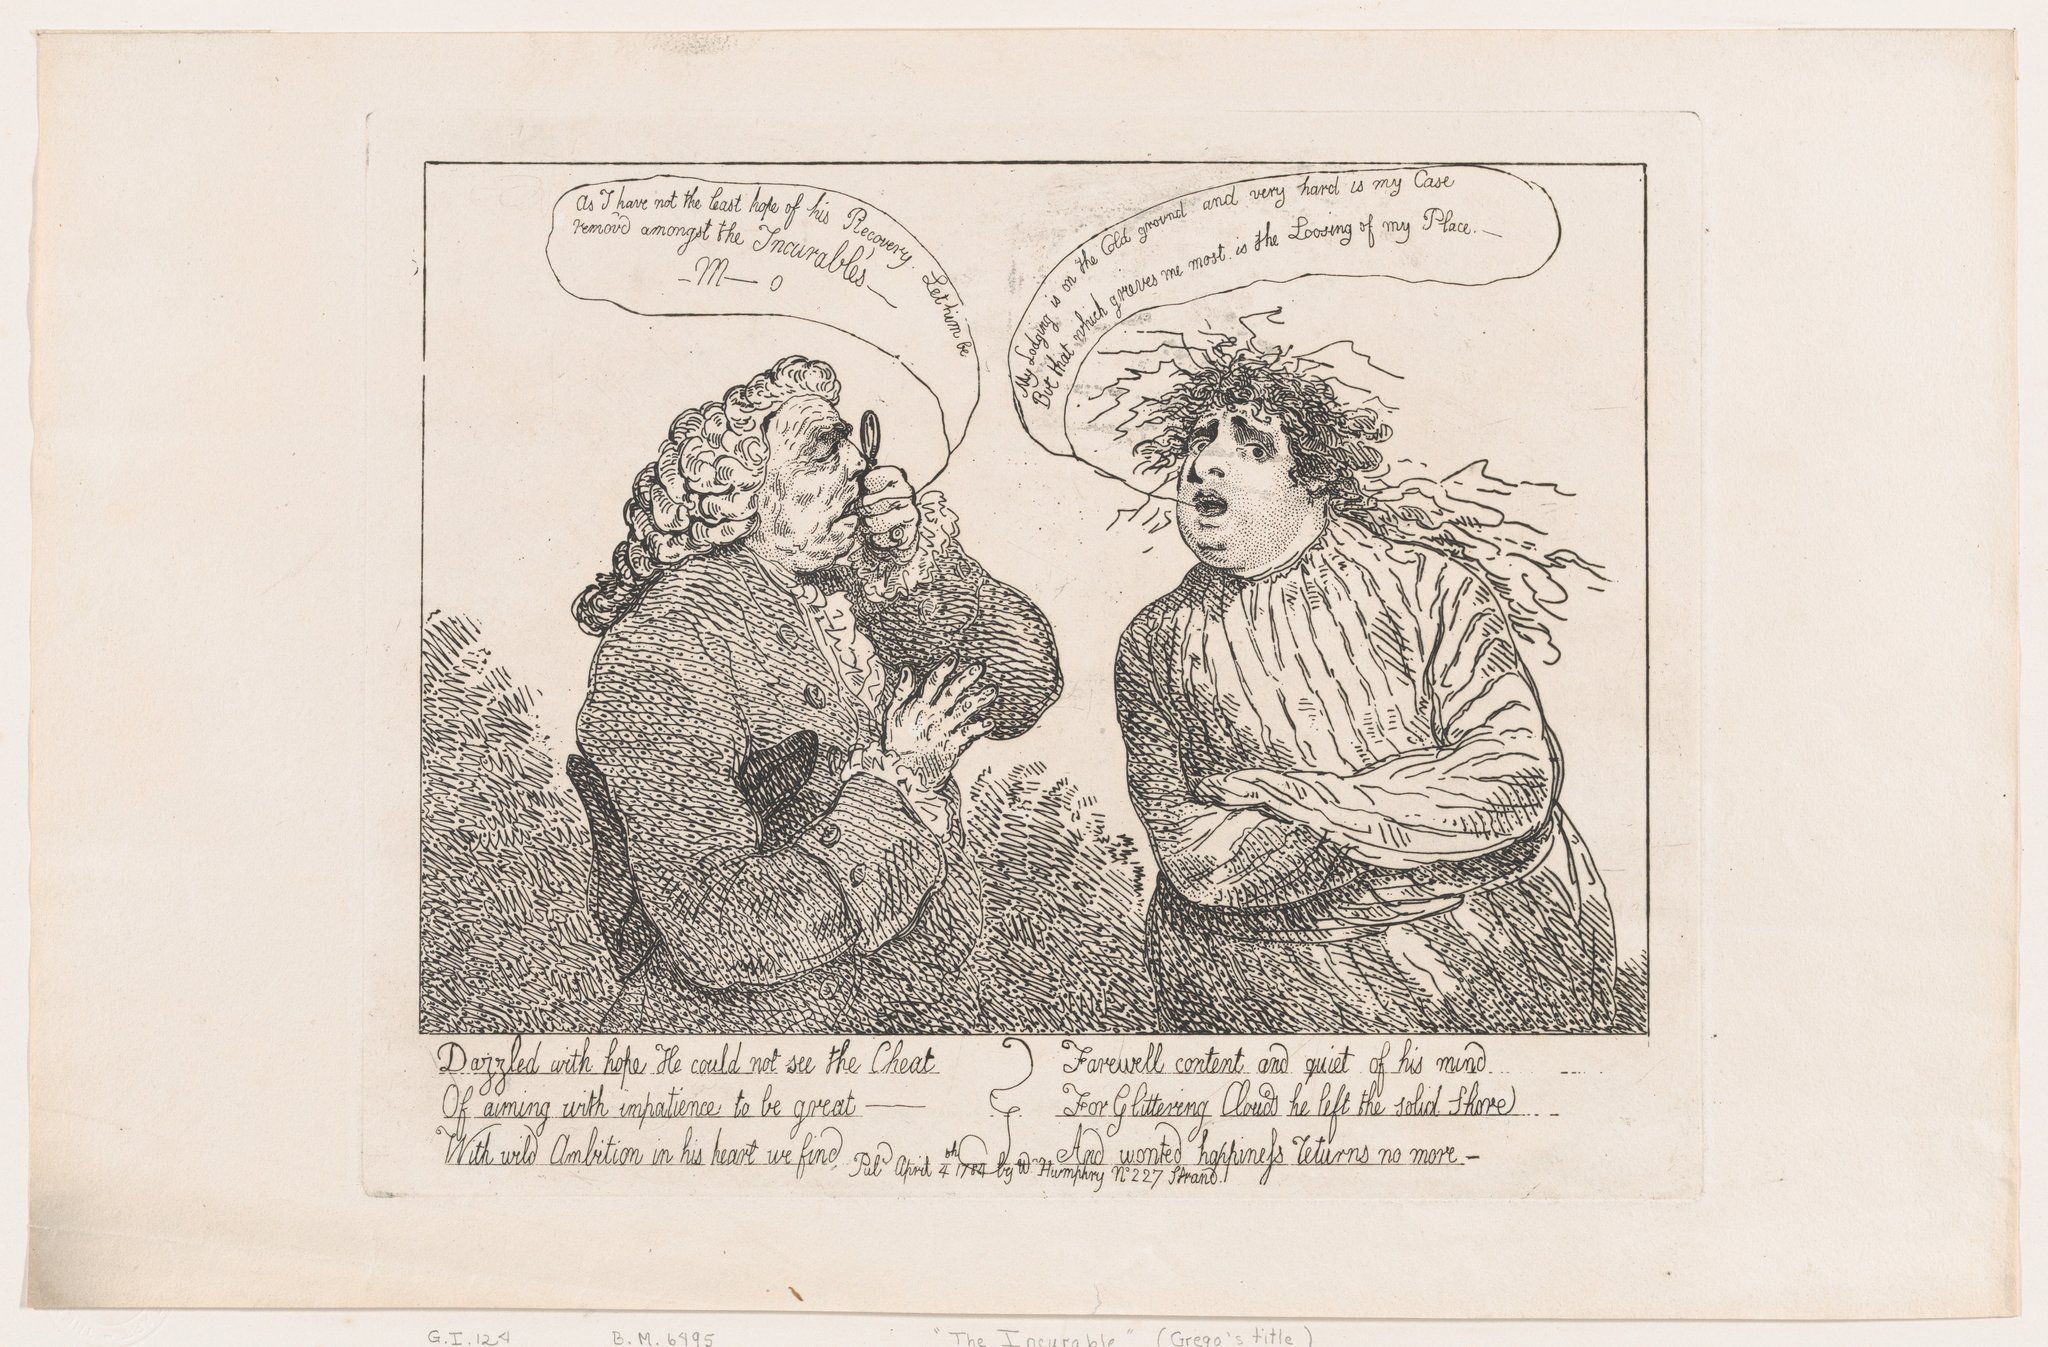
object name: print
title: The Incurable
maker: thomas rowlandson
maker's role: artist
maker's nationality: british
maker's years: 1757-1827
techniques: etching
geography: london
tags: satire,men,politics